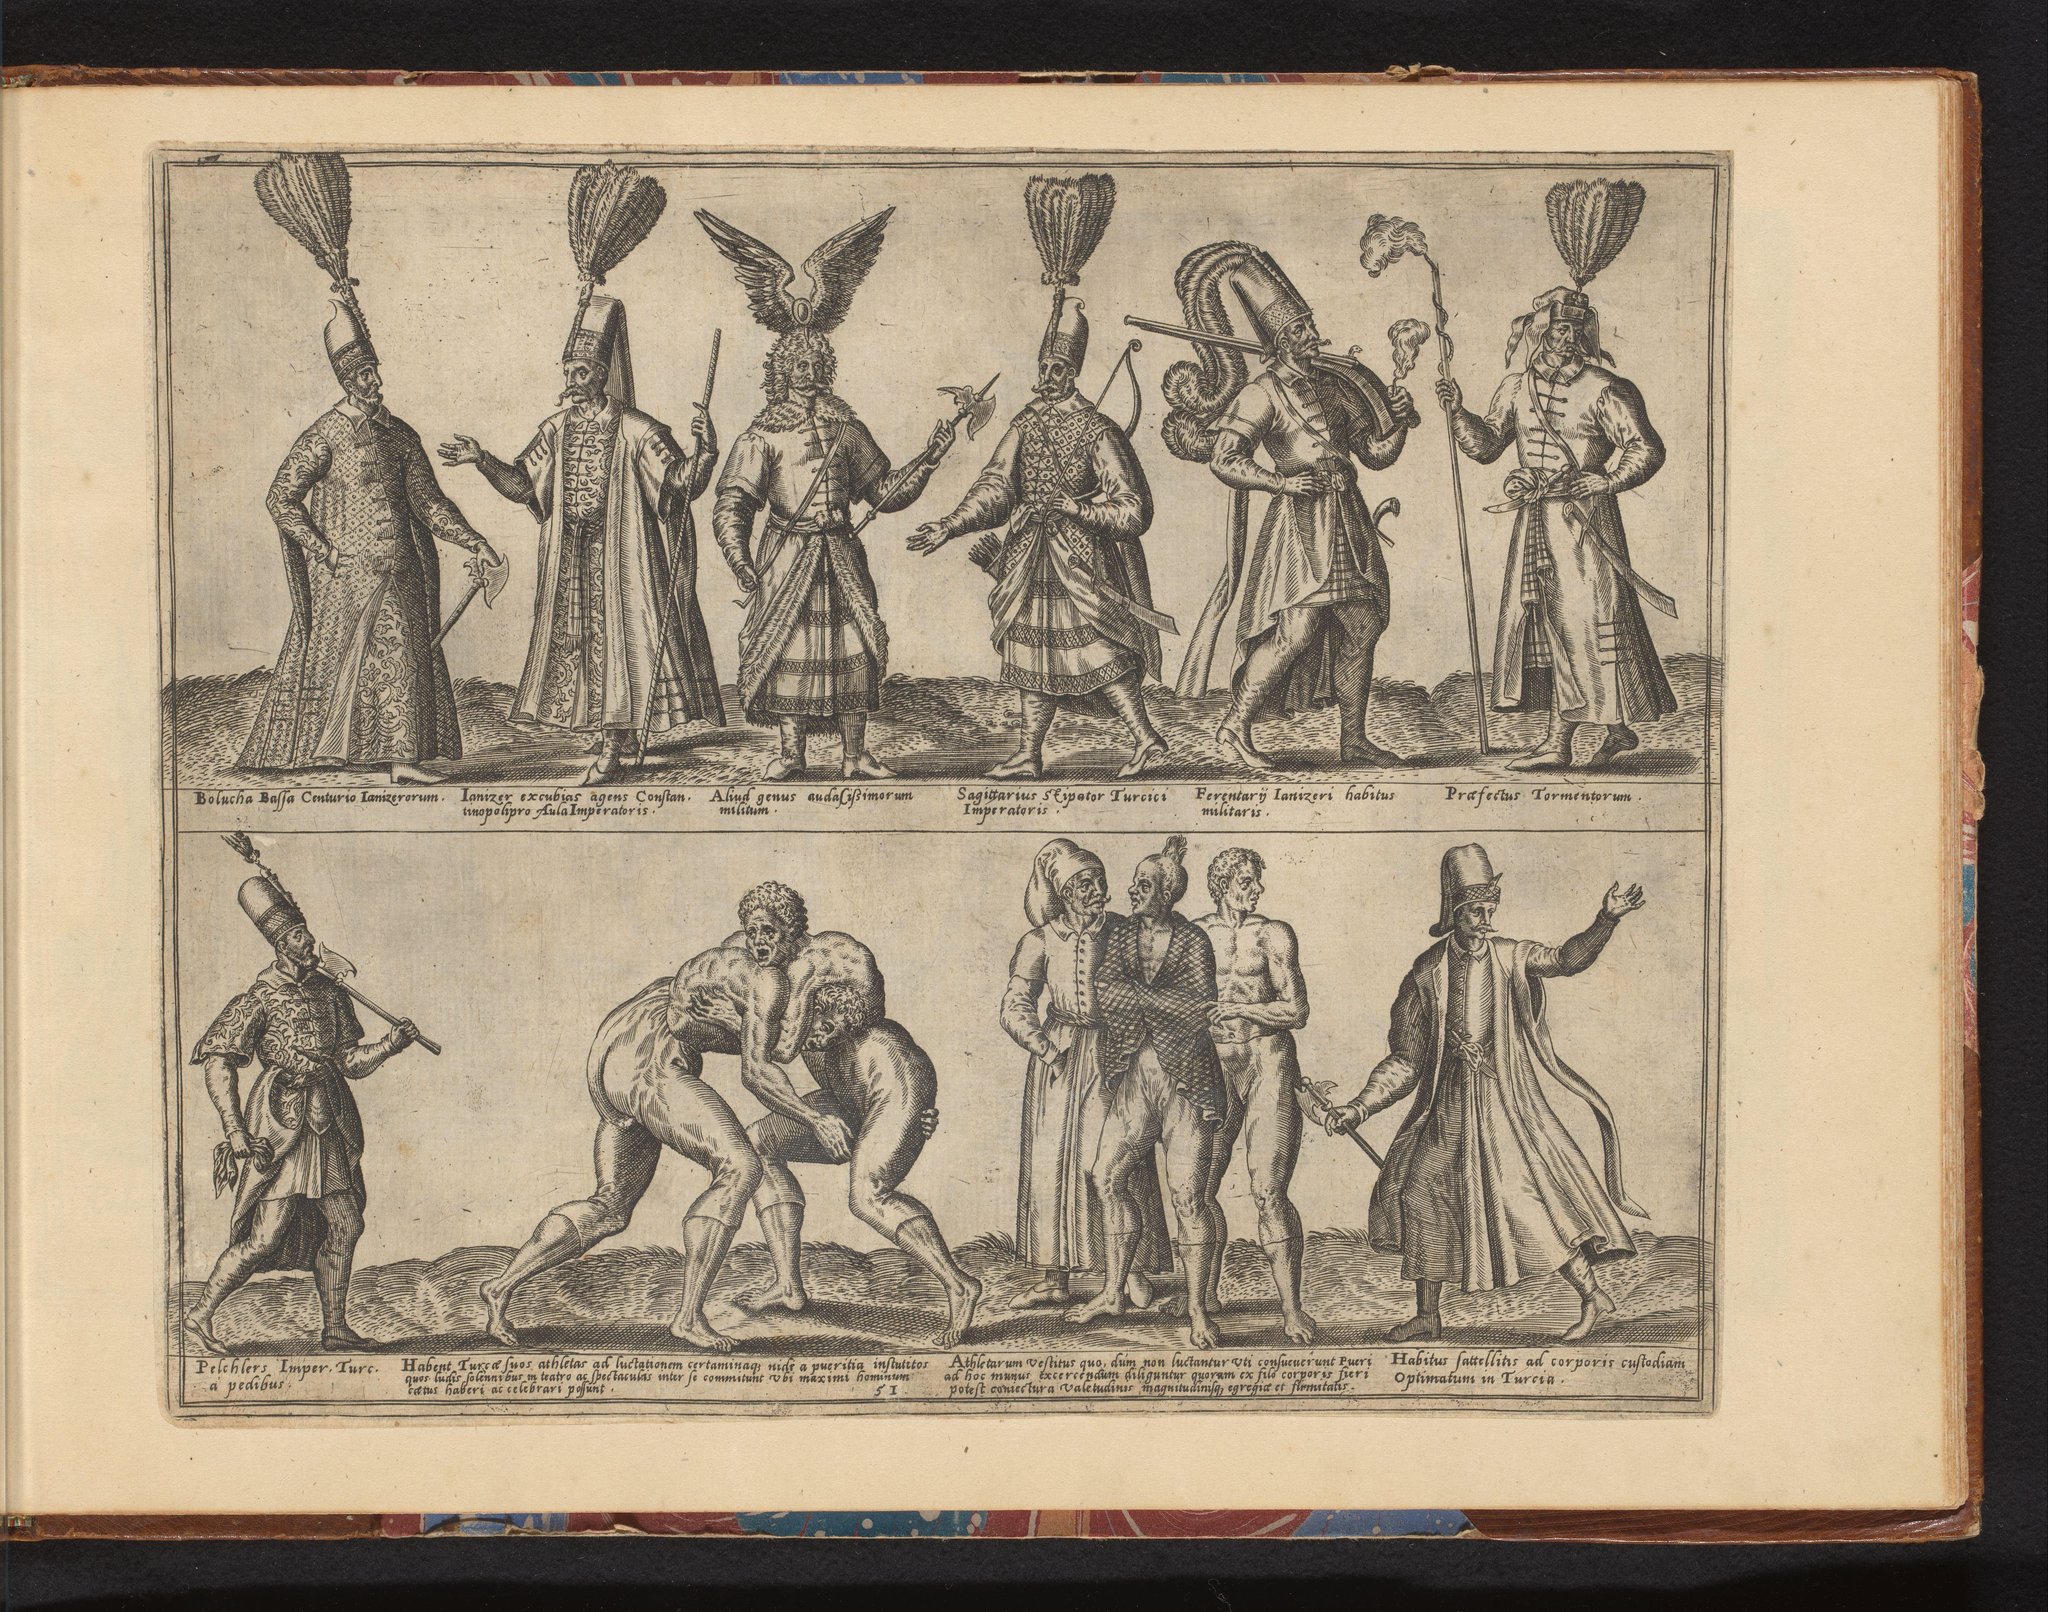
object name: costume print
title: Dertien Turken uit verschillende standen, gekleed volgens de mode van ca. 1580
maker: abraham de bruyn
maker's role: print maker, publisher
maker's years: 1540-1587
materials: paper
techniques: engraving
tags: asiatic races and peoples: turks (+ costume)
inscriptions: number: ‘51’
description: Prent uit het boek 'Omnium pene Europae, Asiae, Aphricae atque Americae gentium habitus...', 1581. De prent maakt deel uit van een album.